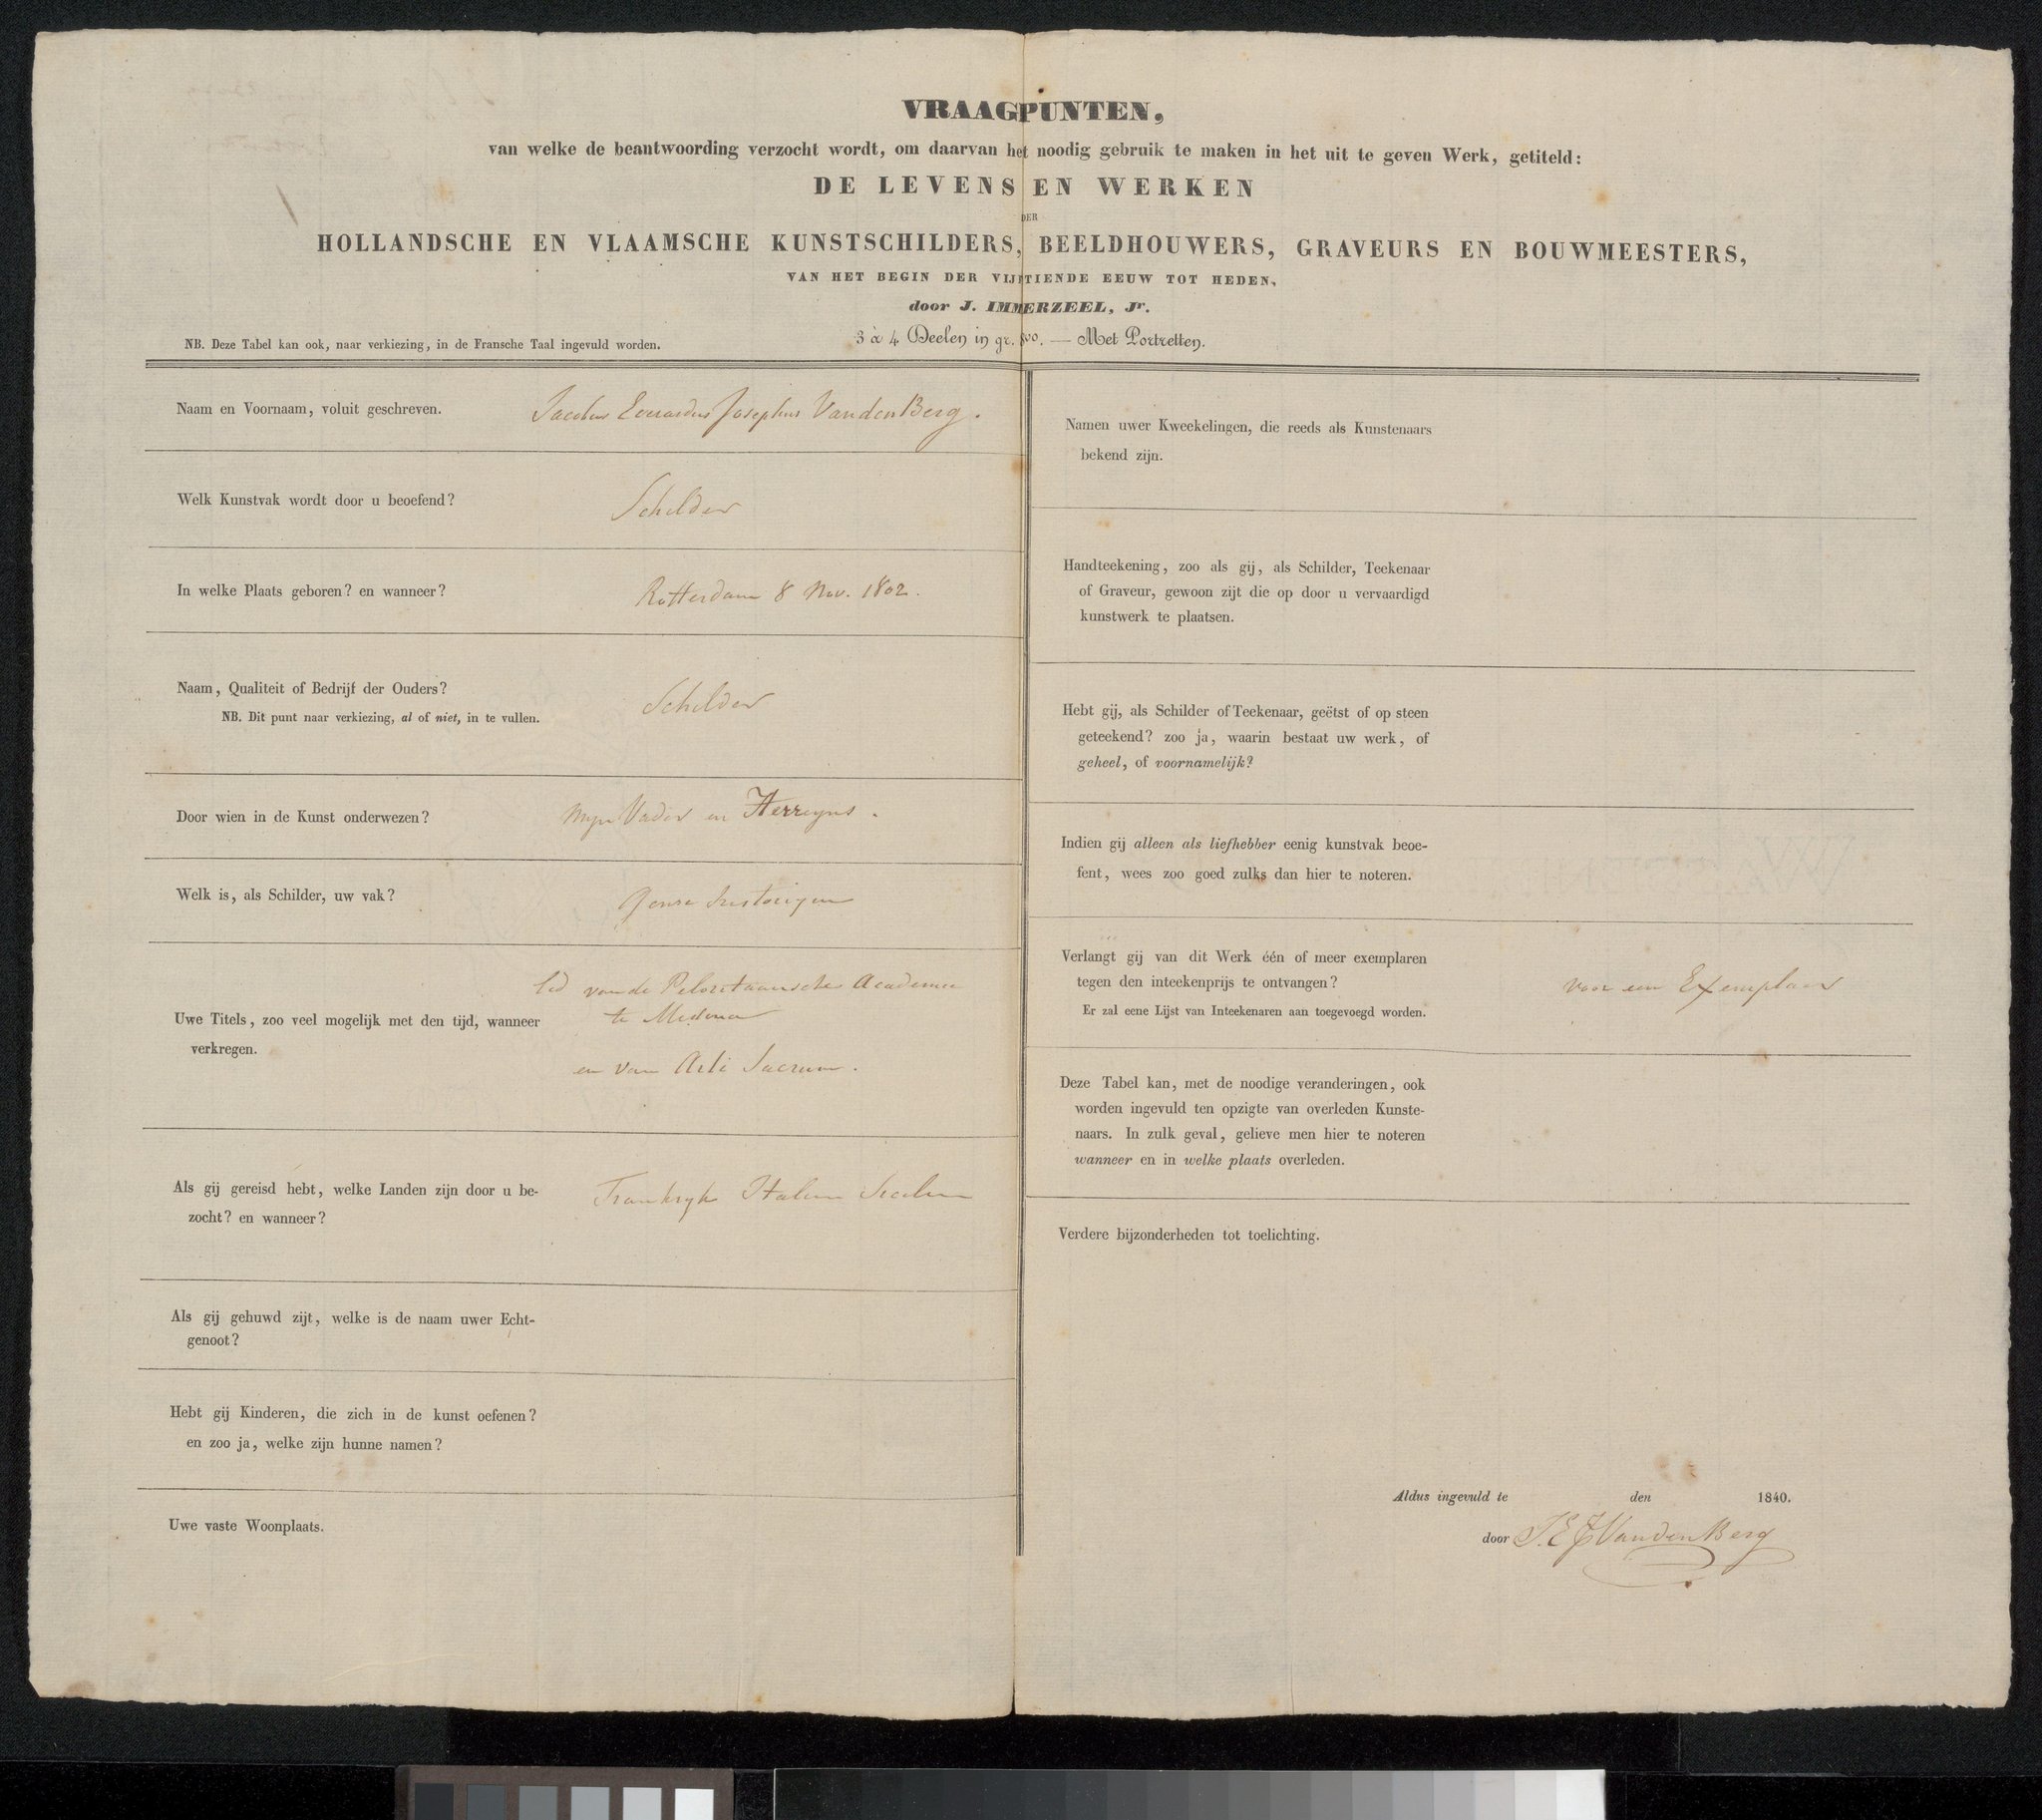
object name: questionnaire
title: Enquêteformulier ingevuld door Jacobus Everhardus Josephus van den Berg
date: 1840-1841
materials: ink, paper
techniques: pen, printing, writing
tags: rotterdam, the hague, draughtsman, jacobus everhardus josephus van den berg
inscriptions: inscription: ‘Vraagpunten,/ van welke de beantwoording verzocht wordt, om daarvan het noodig gebruik te maken in het uit te geven Werk, getiteld: De levens en werken/ der Hollandsche en Vlaamsche kunstschilders, beeldhouwers,/ graveurs en bouwmeesters, van het begin der vijftiende eeuw tot heden/ door J. Immerzeel, Jr.’, watermark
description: Opgenomen in: Immerzeel, J. Jr., De levens en werken der Hollandsche en Vlaamsche kunstschilders, beeldhouwers, graveurs en bouwmeesters, van het begin der vijftiende eeuw tot heden, Amsterdam: J.C. van Kesteren, 1842-1843.